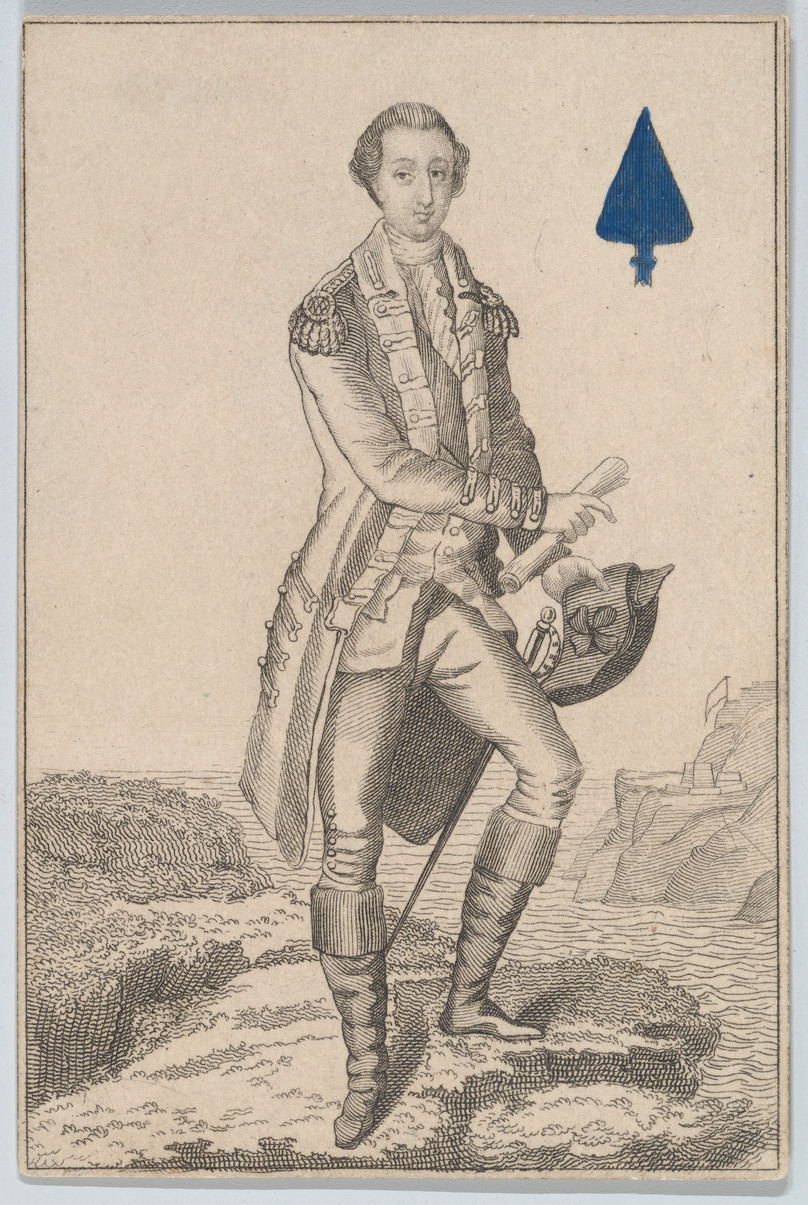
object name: print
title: King (Washington from the United States), from "Court Game of Geography"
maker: william and henry rock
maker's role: publisher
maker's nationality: british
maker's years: 1821-1884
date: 1838-1855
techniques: engraving, etching, hand coloring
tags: george washington,playing cards